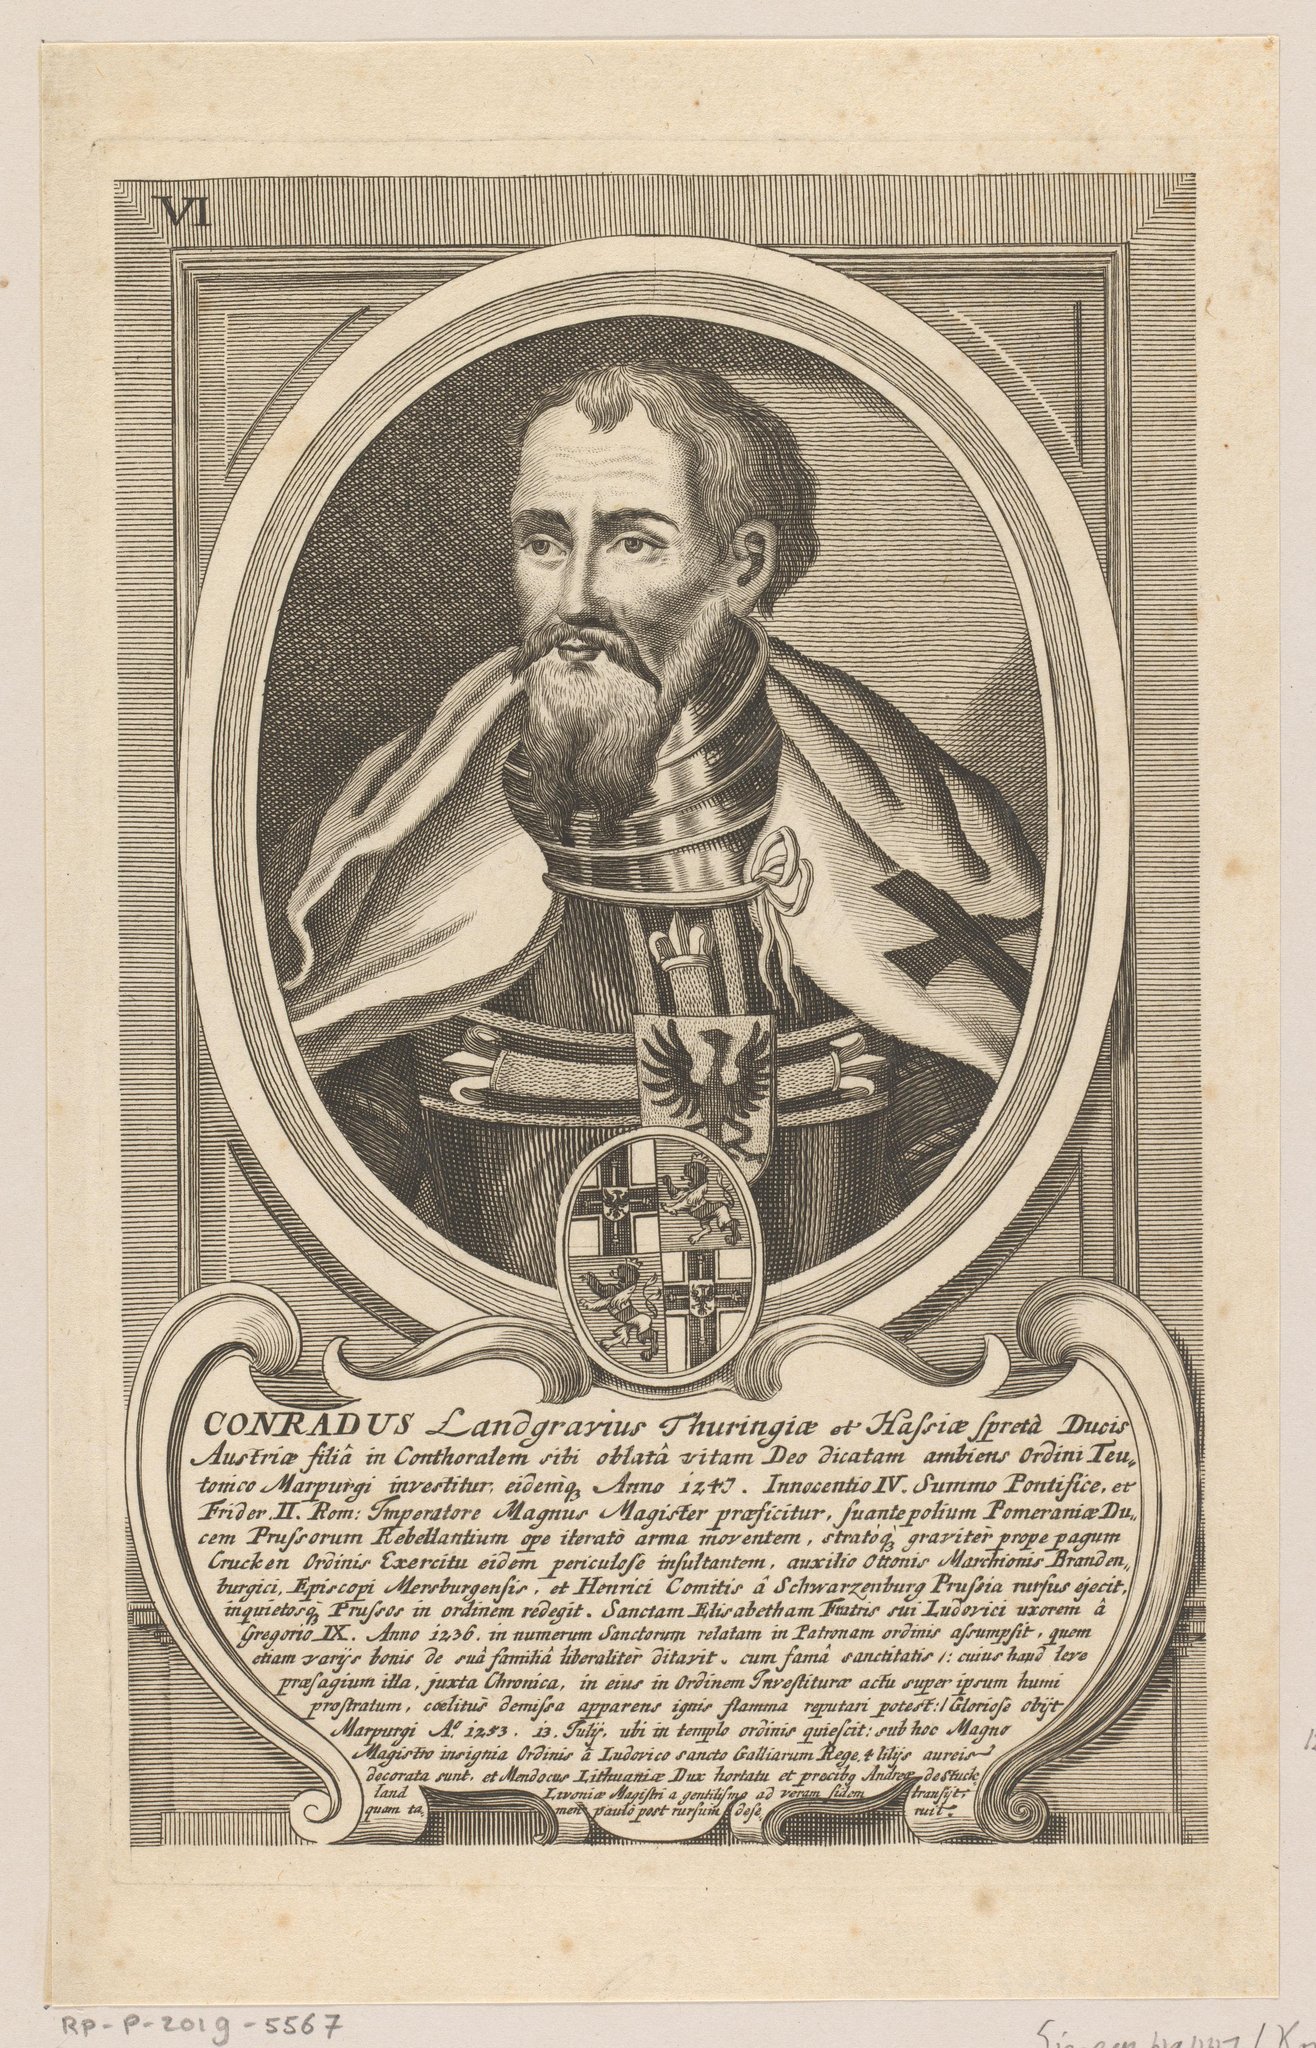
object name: book illustration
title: Conradus Landgravius Thuringiae et Halsiae (...)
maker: johann salver (i)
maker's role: print maker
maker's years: 1670-1738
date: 1720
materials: paper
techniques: engraving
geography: würzburg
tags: knighthood order: teutonic order - insignia of a knighthood order, e.g.: badge, chain (with name of order), historical persons, armorial bearing, heraldry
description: Prent uit: [Salver, Johann]. De origine, secundis et adversis successibus, nec non de statu moderno inclyti ordinis equestris hospitalis b.m.v. Teutonicorum in Jerusalem. Würzburg: Johann Salver, [ca. 1720].